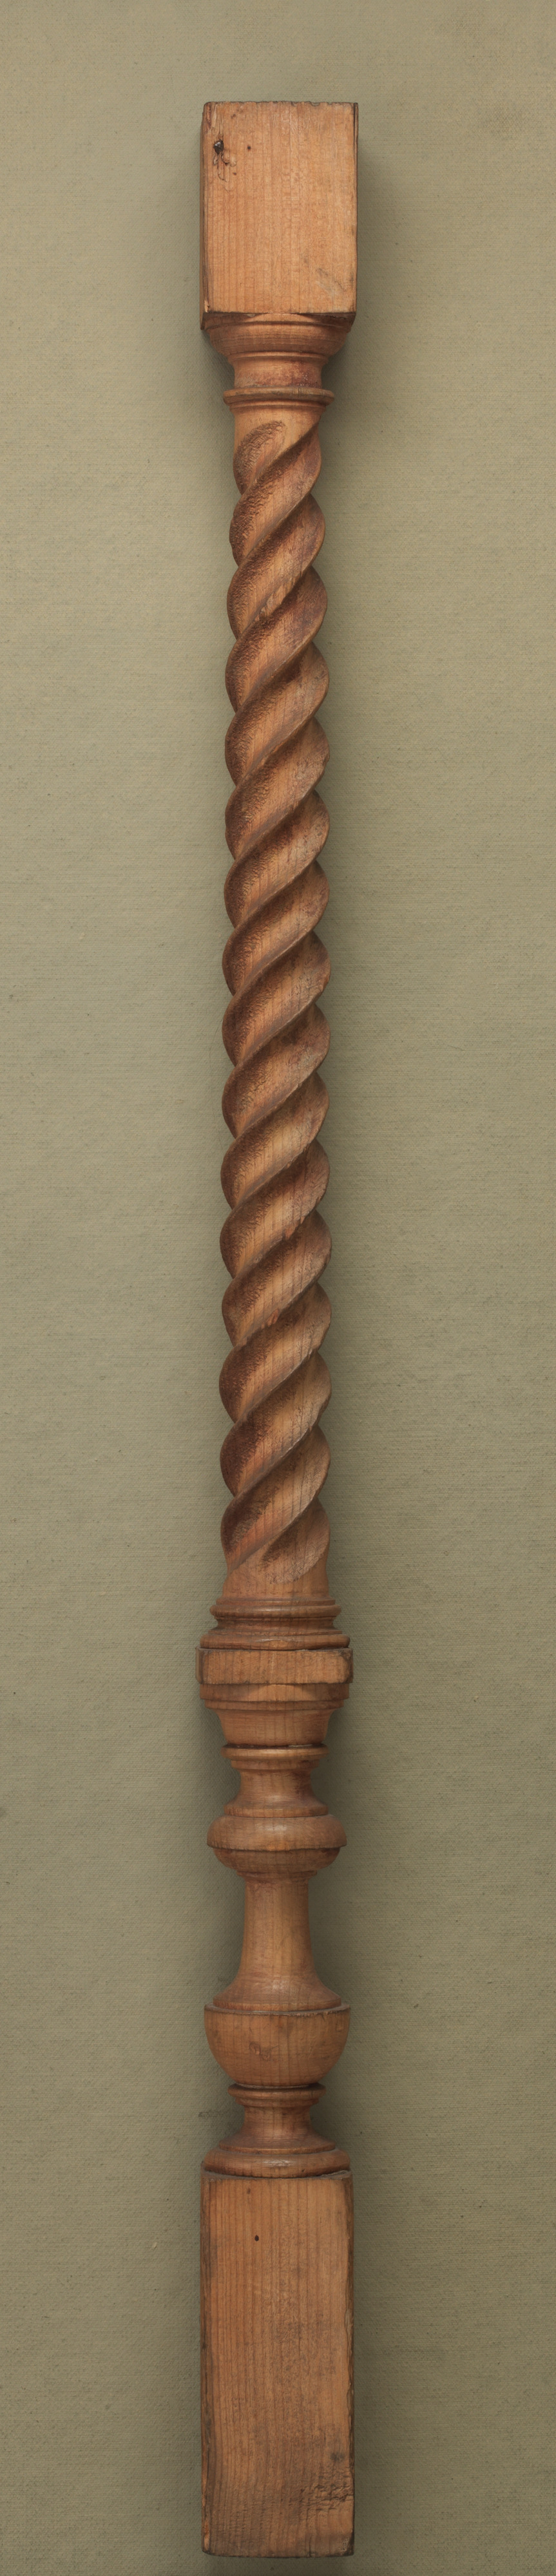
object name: baluster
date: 1734-1766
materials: wood